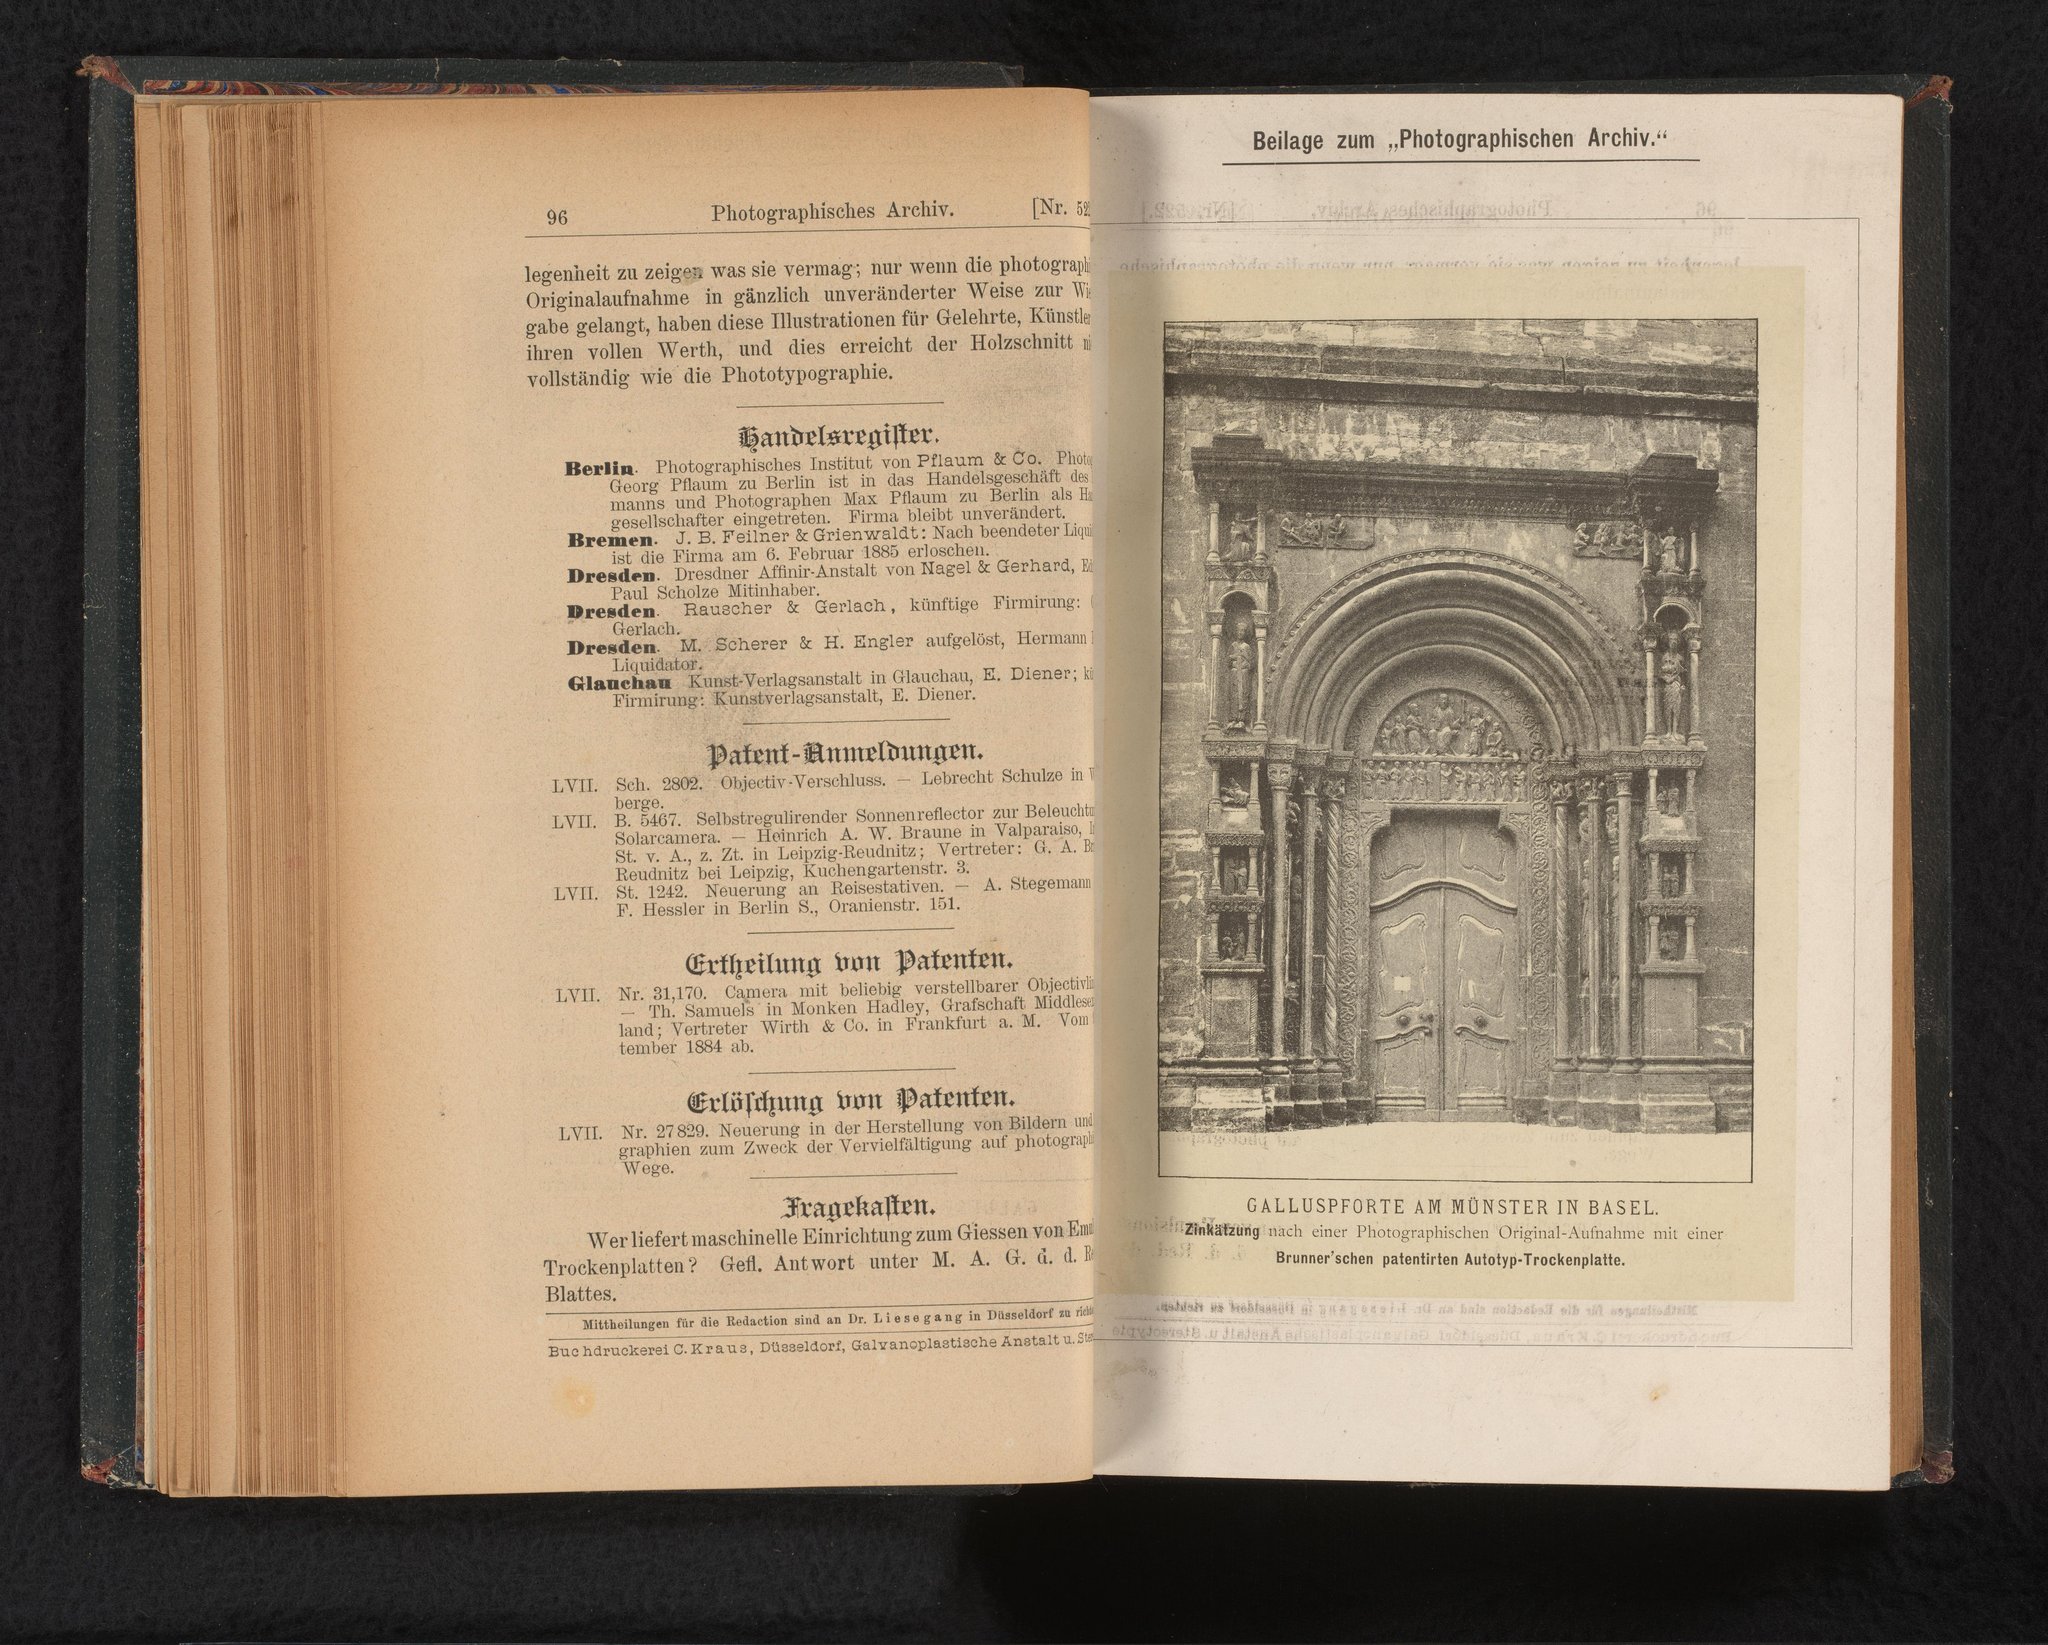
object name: page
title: Portaal van het Münster in Basel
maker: Anonymous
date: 1880-1885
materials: paper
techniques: autotype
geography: basel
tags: parts of church exterior and annexes: portal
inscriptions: inscription: ‘Zinkätzung nach einer Photographischen Original-Aufnahme mit einer/ Brunner'schen patentirten Autotyp-Trockenplatte.’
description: Prent op ongenummerde pagina tegenover pagina 96.